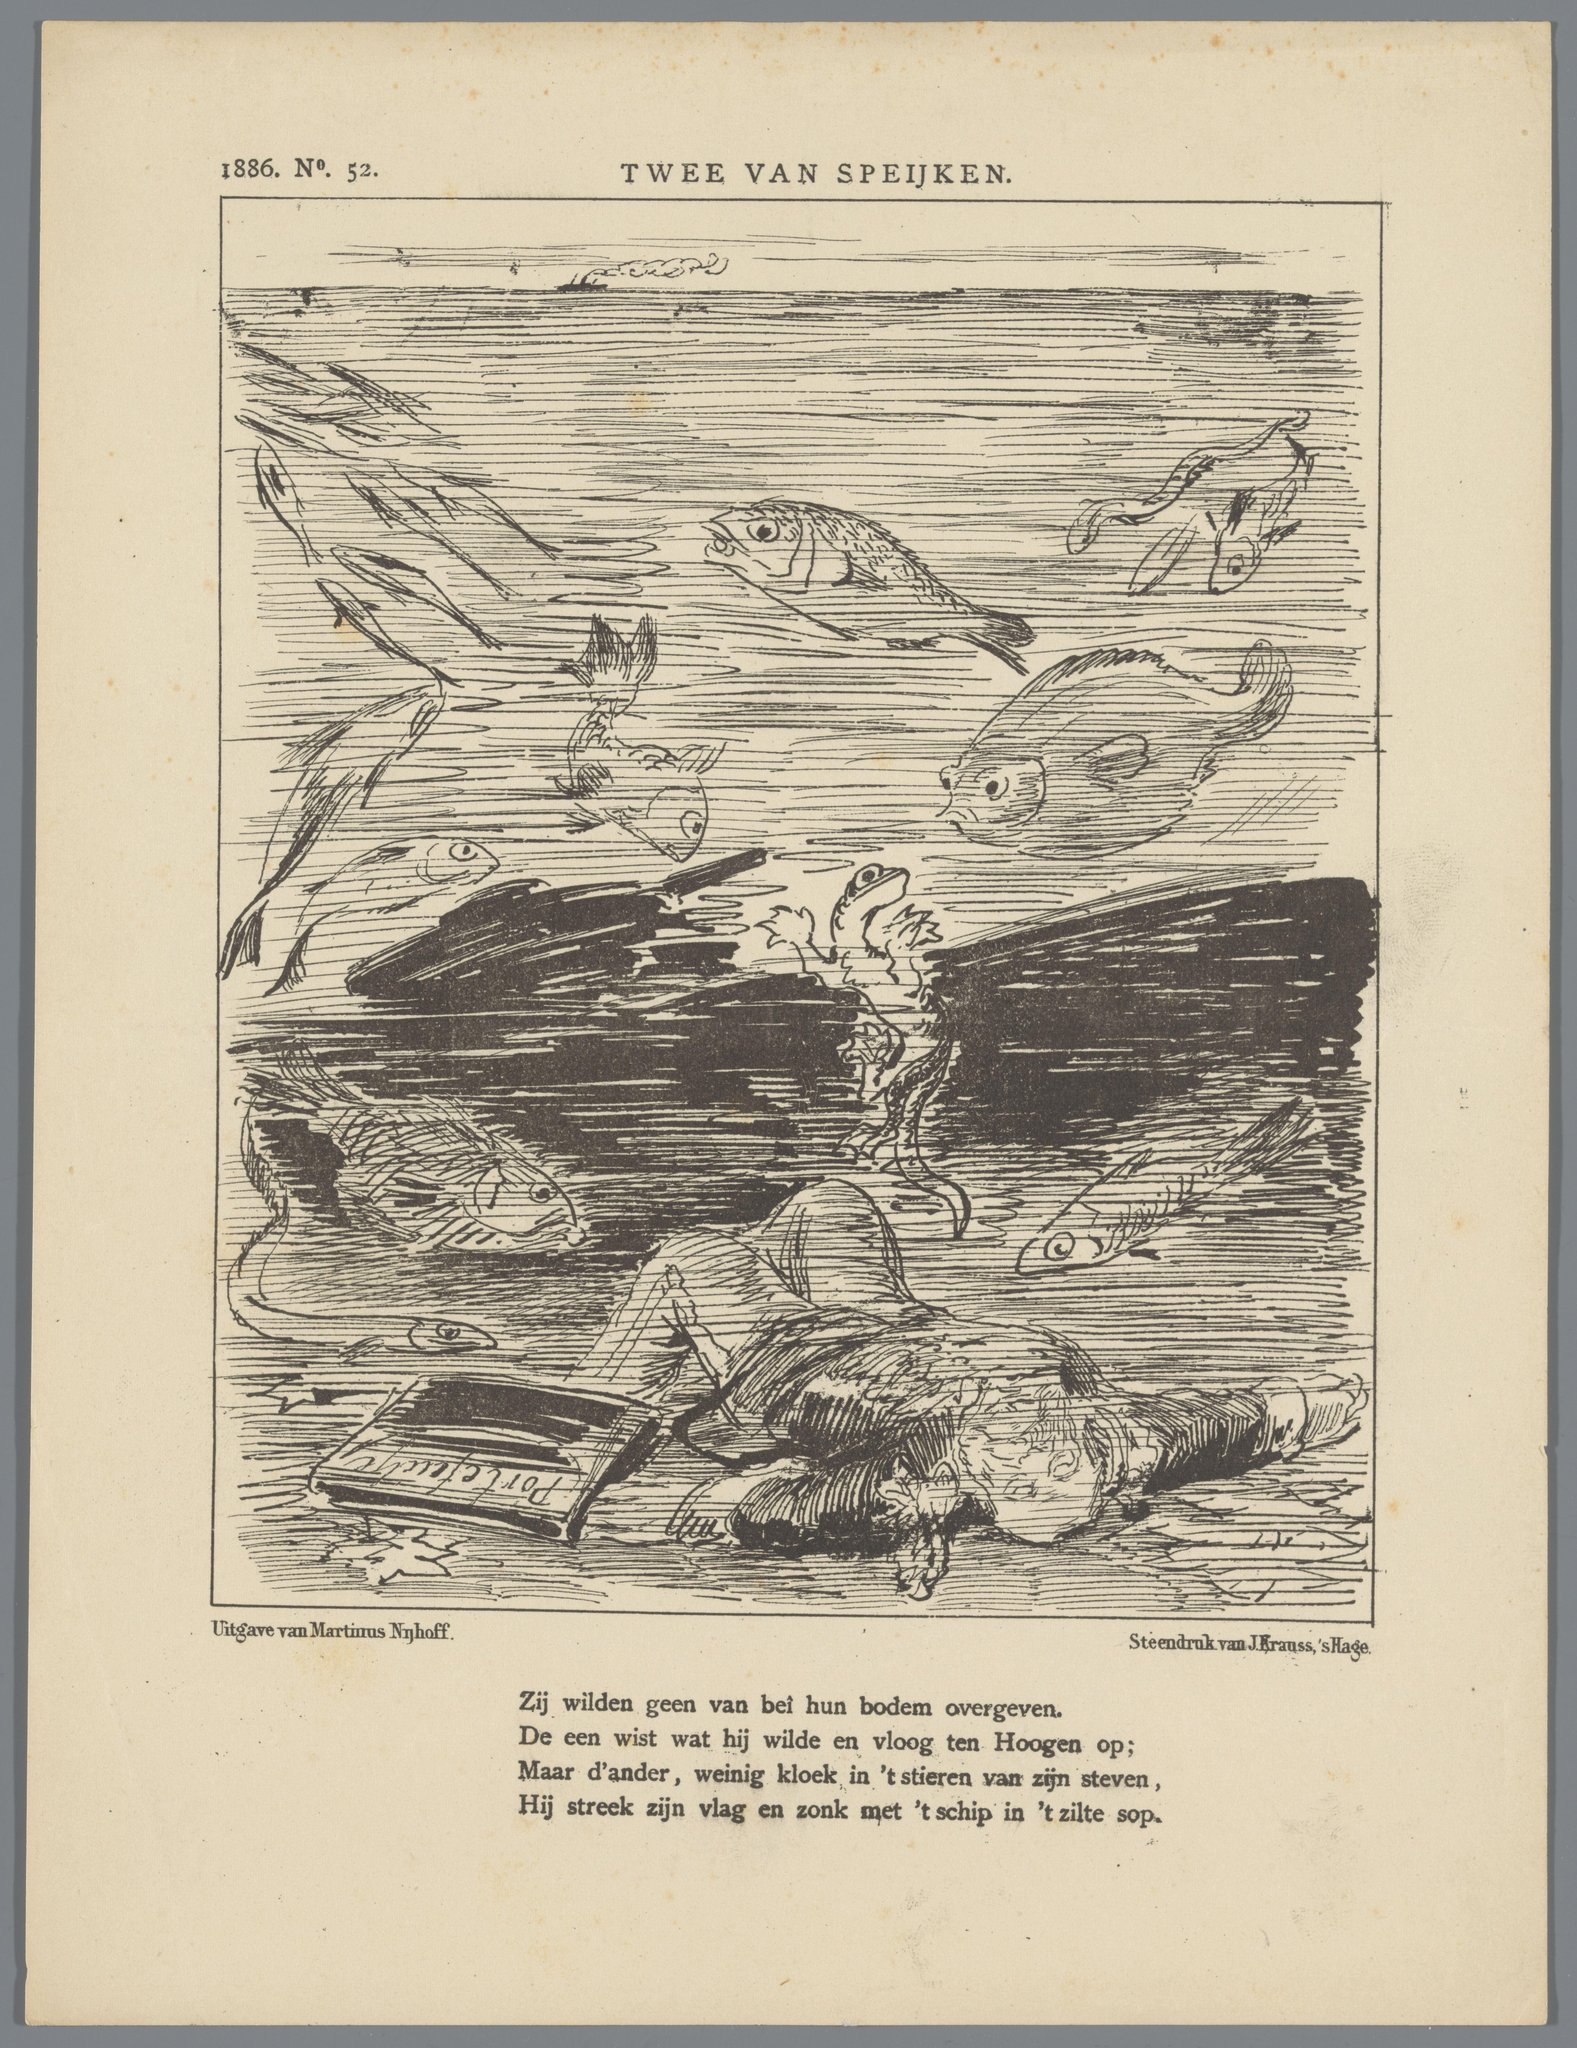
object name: print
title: Spotprent over de val van een minister, 1886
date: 1886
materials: paper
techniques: lithograph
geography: netherlands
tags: antwerp, jan van speyk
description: Spotprent over de val van een minister vergeleken met de zelfopoffering van Jan van Speyk. Plaat verschenen bij het weekblad De Nederlandsche Spectator, nr. 52, 1886.